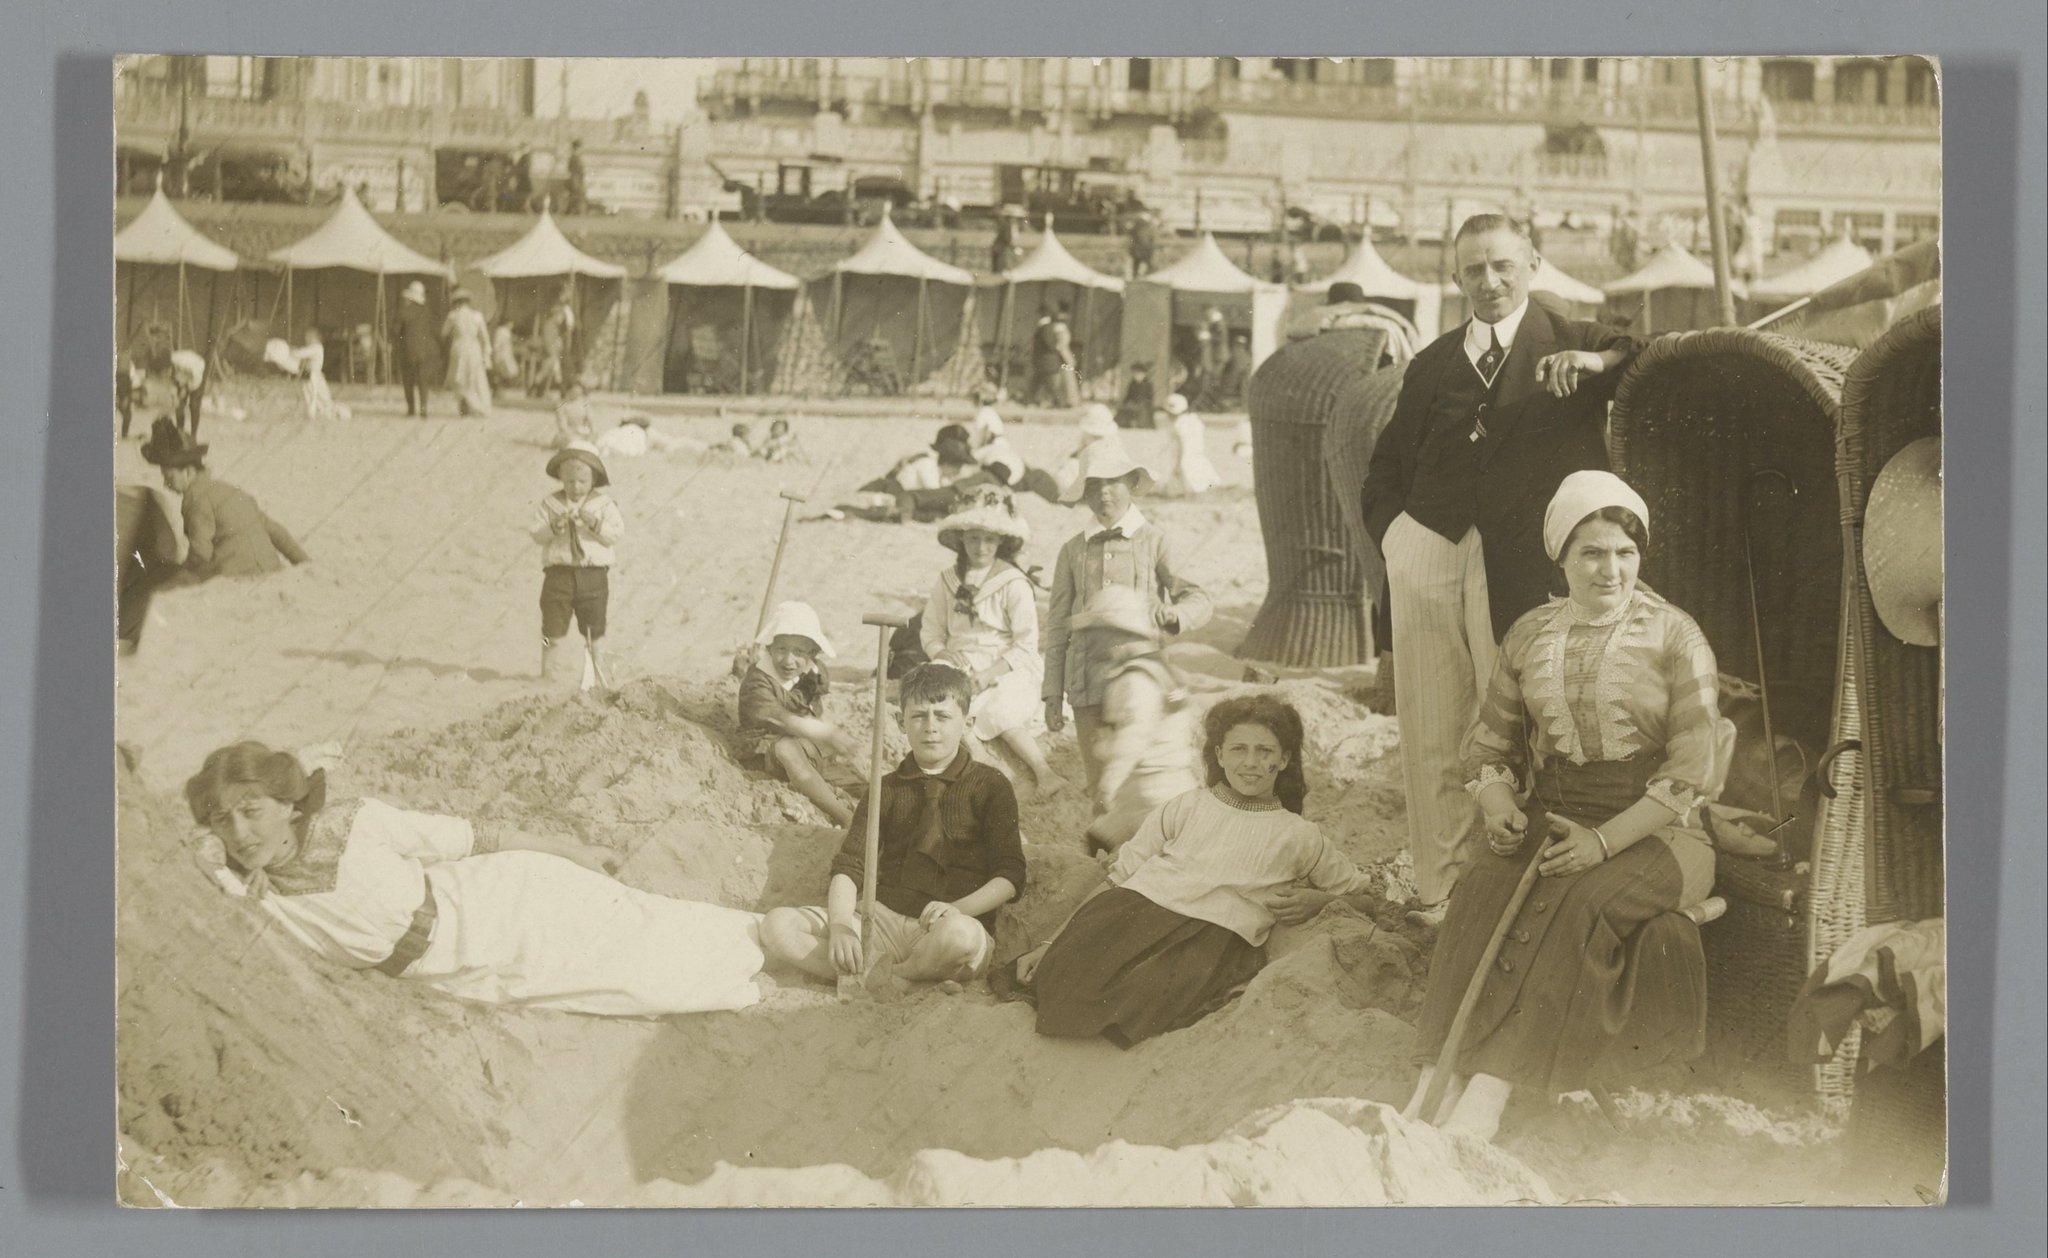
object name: ansichtkaart, prentbriefkaart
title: Portret van een onbekende familie op het strand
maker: Anonymous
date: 1910-1925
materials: photographic support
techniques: gelatin silver print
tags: beach (as place of recreation), family group, especially parents with their child(ren)